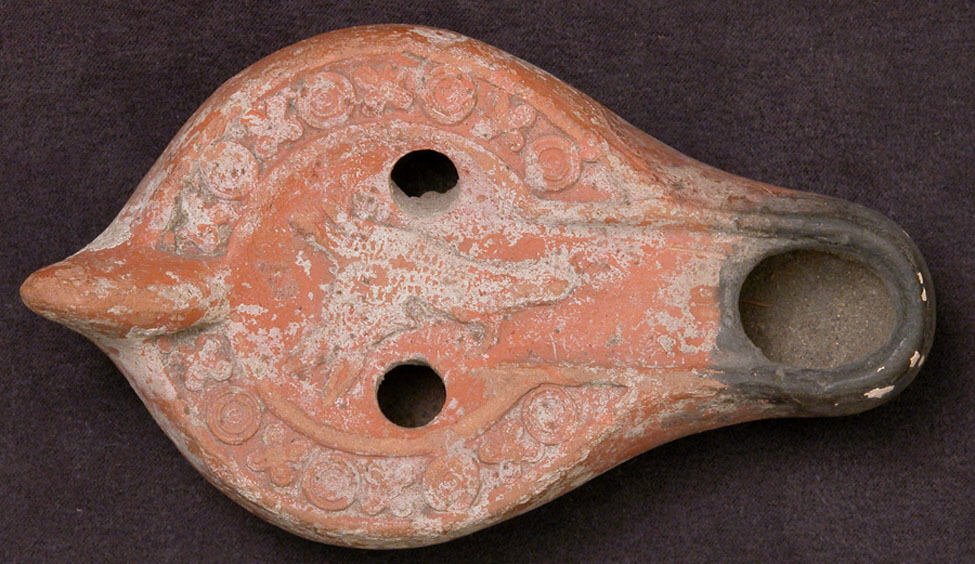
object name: lamp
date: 401-600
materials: earthenware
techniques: molding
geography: egypt